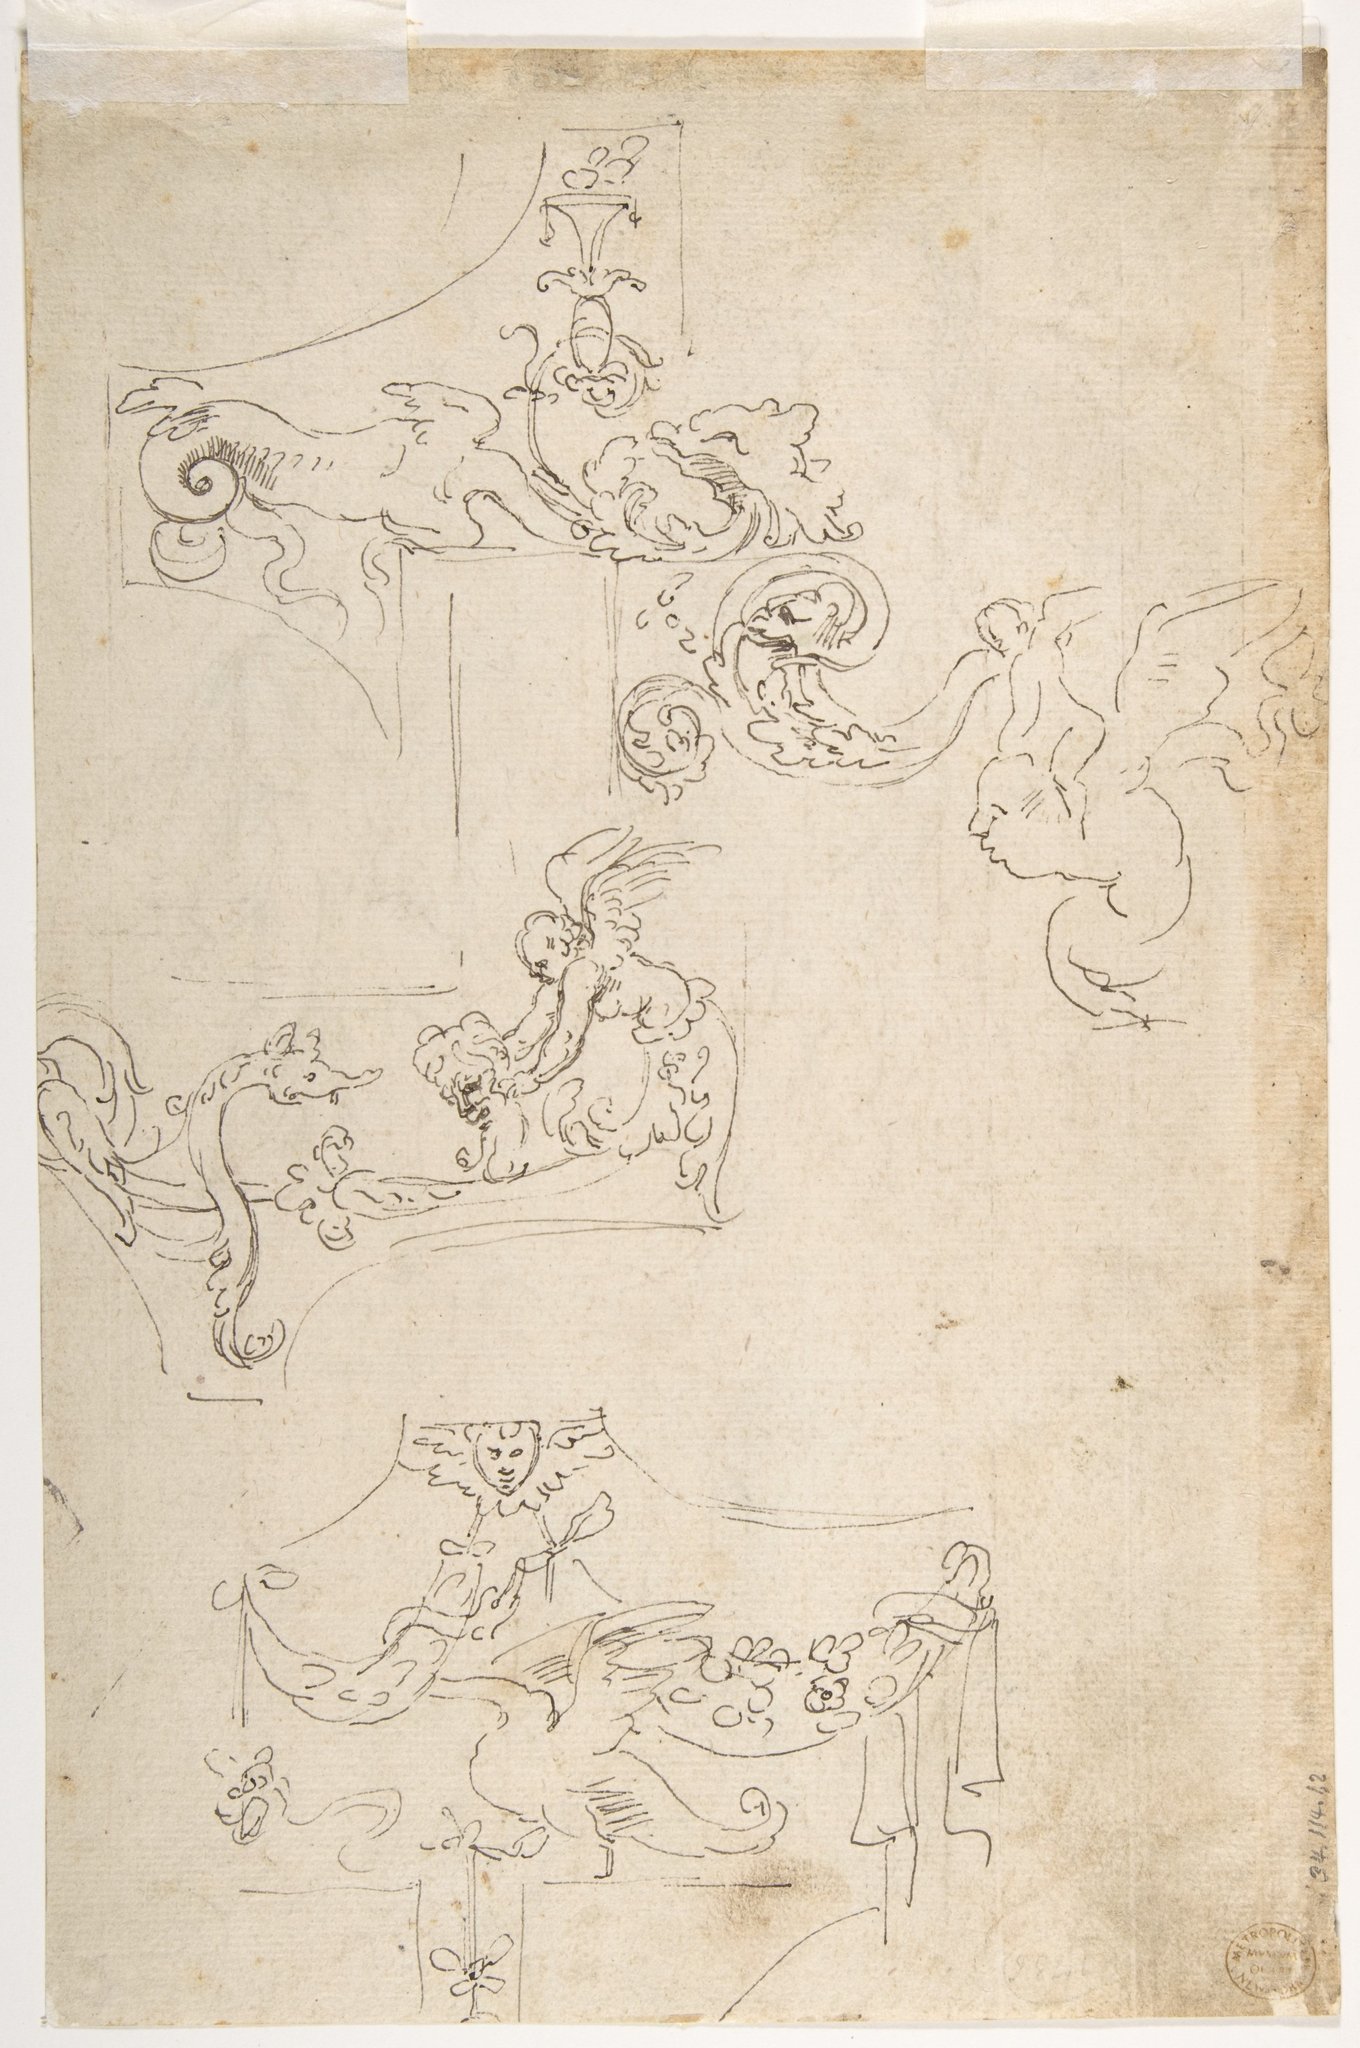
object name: drawing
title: Sheet of Figure Studies, Probably after the Antique (recto); Ornamental Designs (verso)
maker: girolamo da carpi (girolamo sellari)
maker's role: artist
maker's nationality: italian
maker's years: 1501-1556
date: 1501-1556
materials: ink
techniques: brush, pen, wash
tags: ornament,men,horses